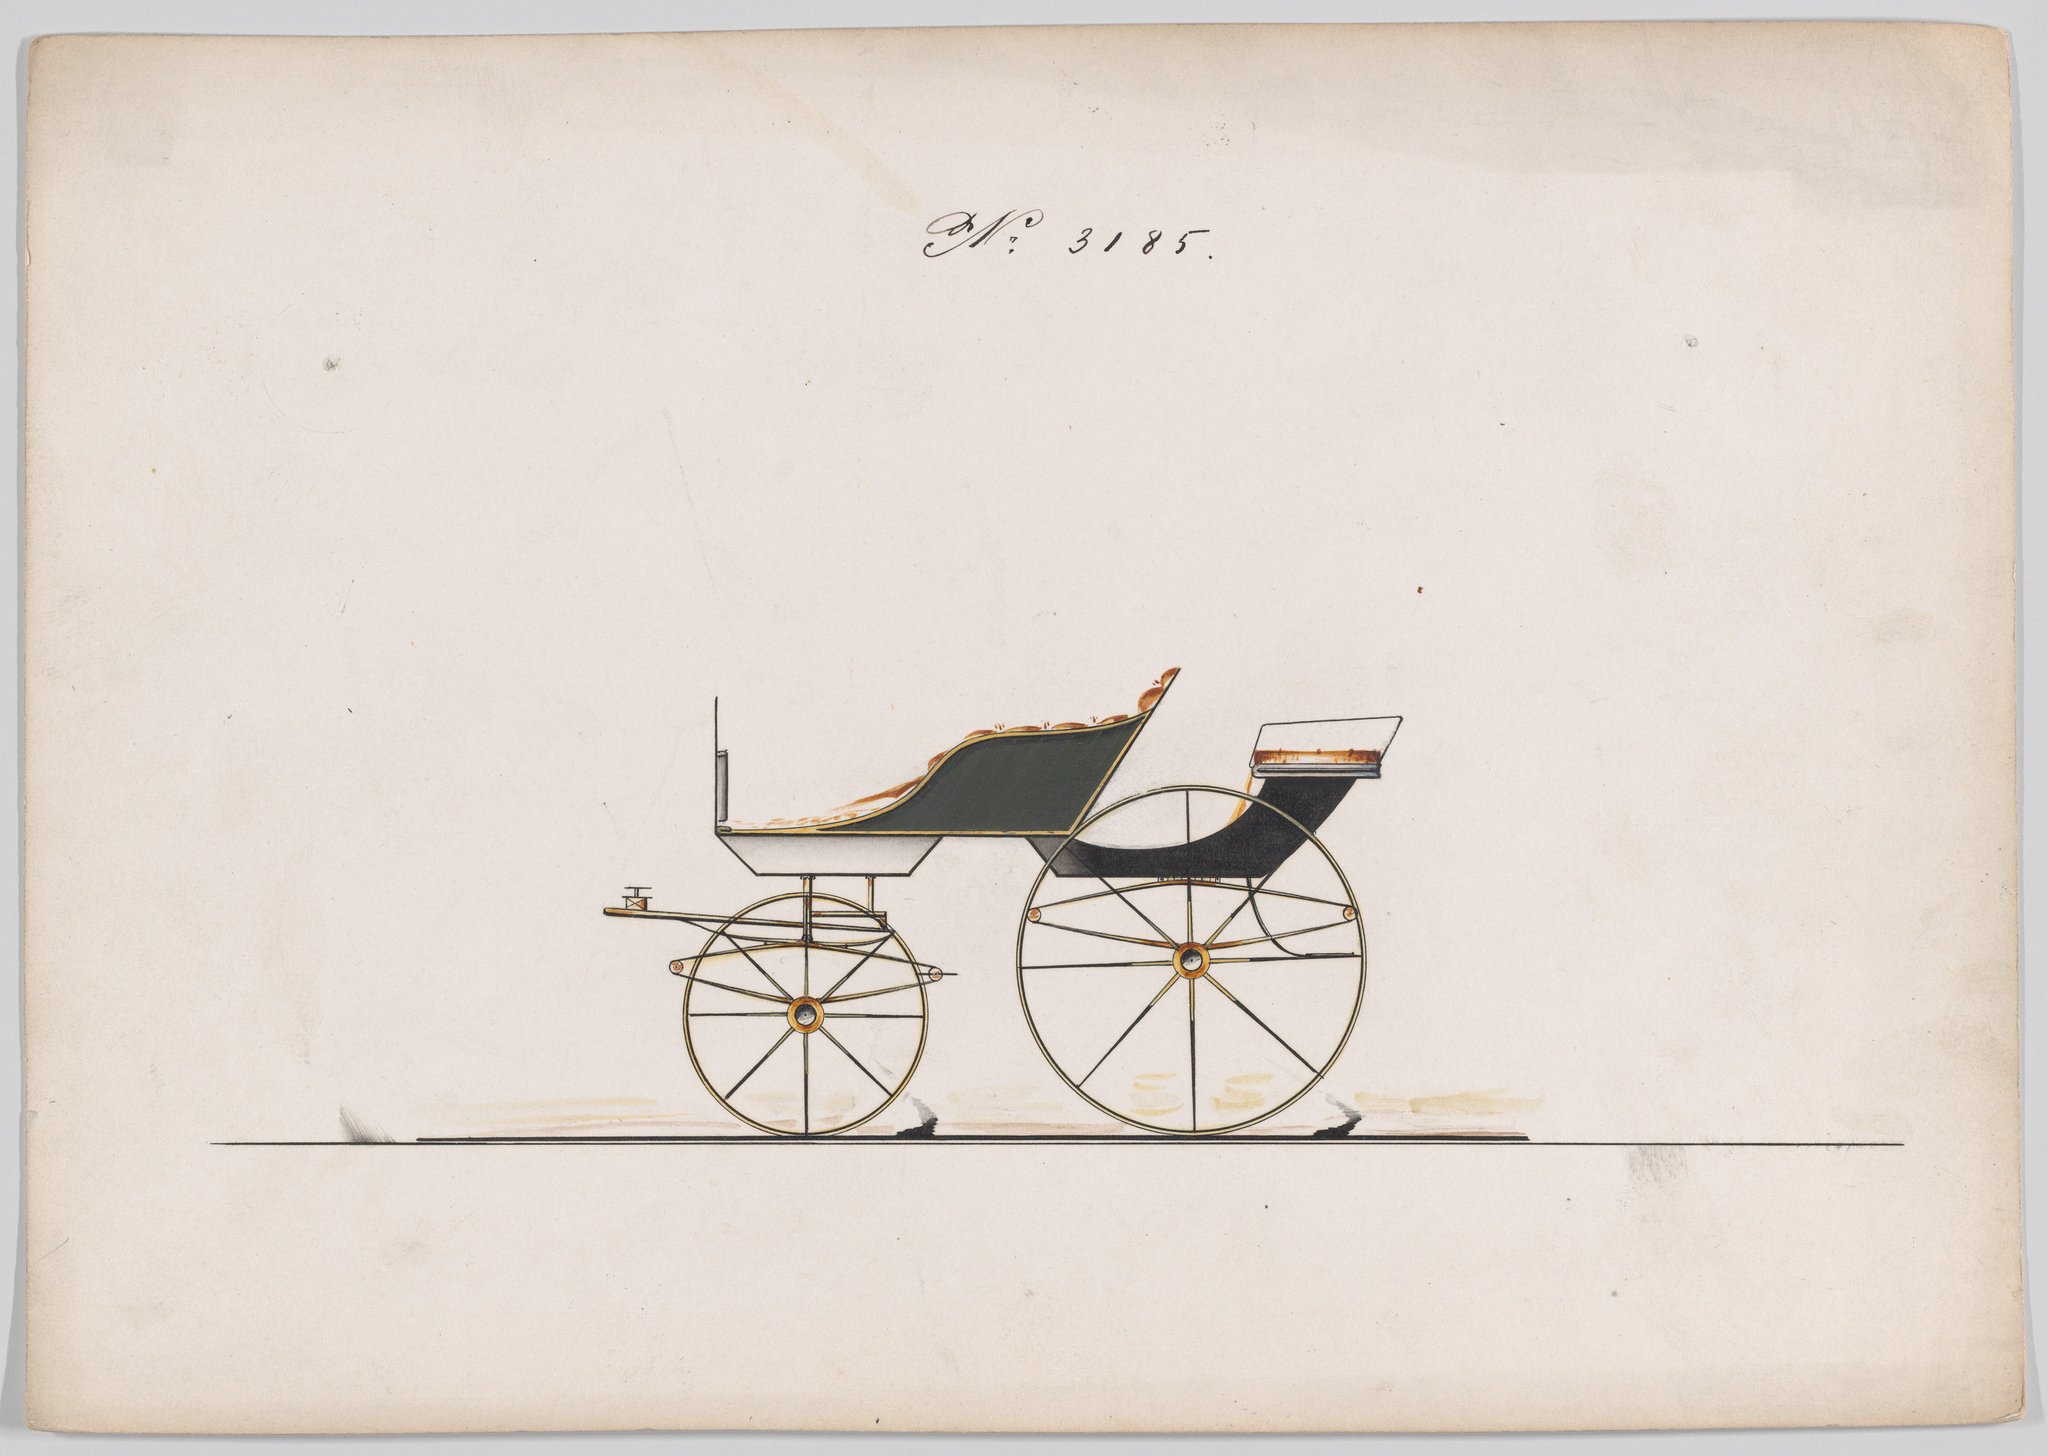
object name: drawing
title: Design for Pony Phaeton, no. 3185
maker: brewster & co.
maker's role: manufacturer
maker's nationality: american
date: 1876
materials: ink, watercolor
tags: carriages